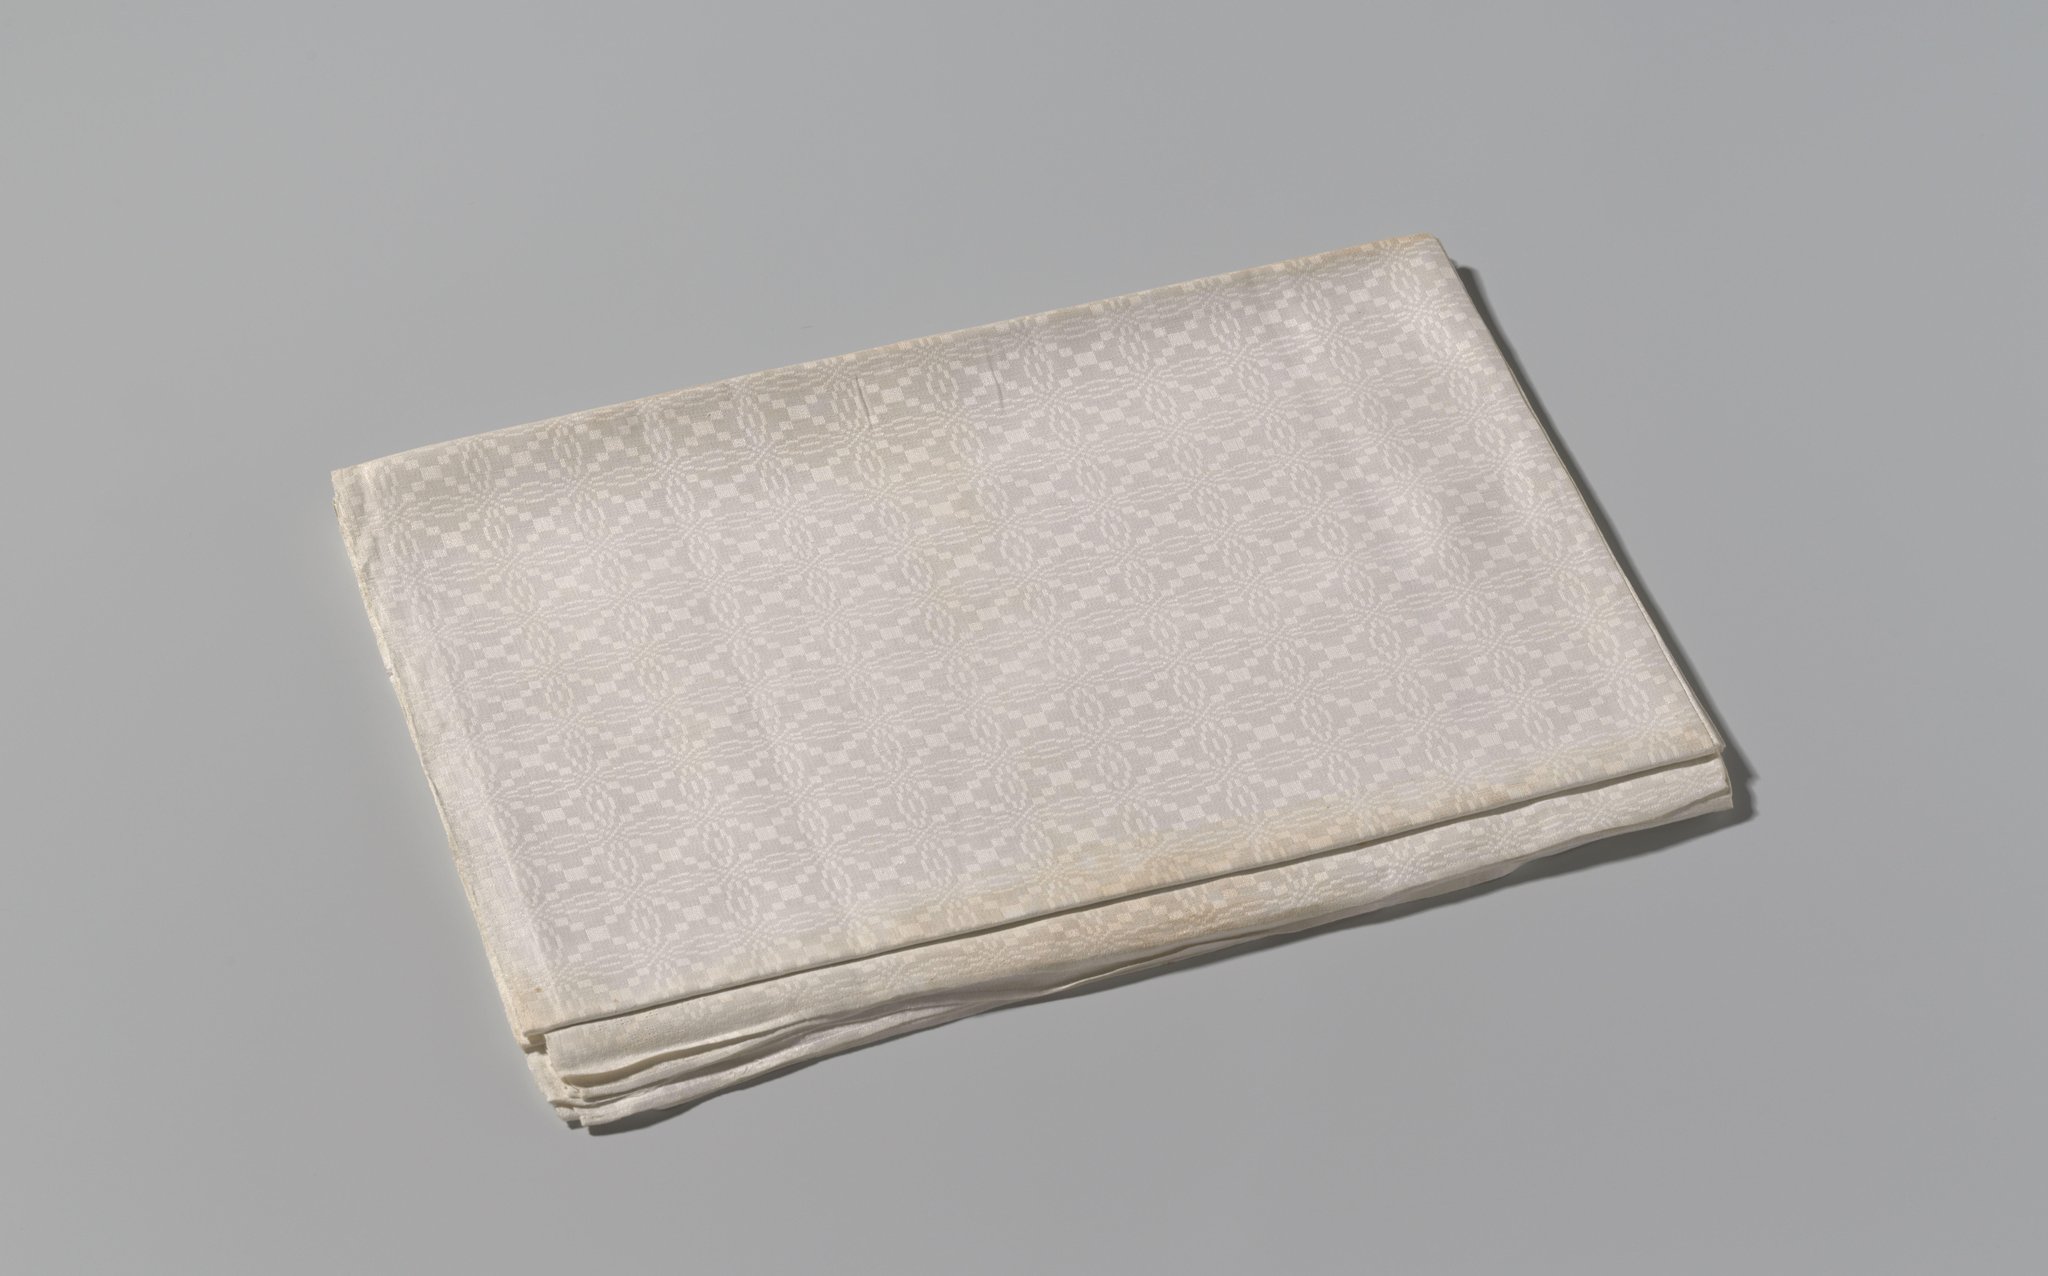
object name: tablecloth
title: Tafellaken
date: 1630-1670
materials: linen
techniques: peeled fabric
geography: northern netherlands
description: Wit linnen tafellaken met pellen patroon. Merk AVR en HB.